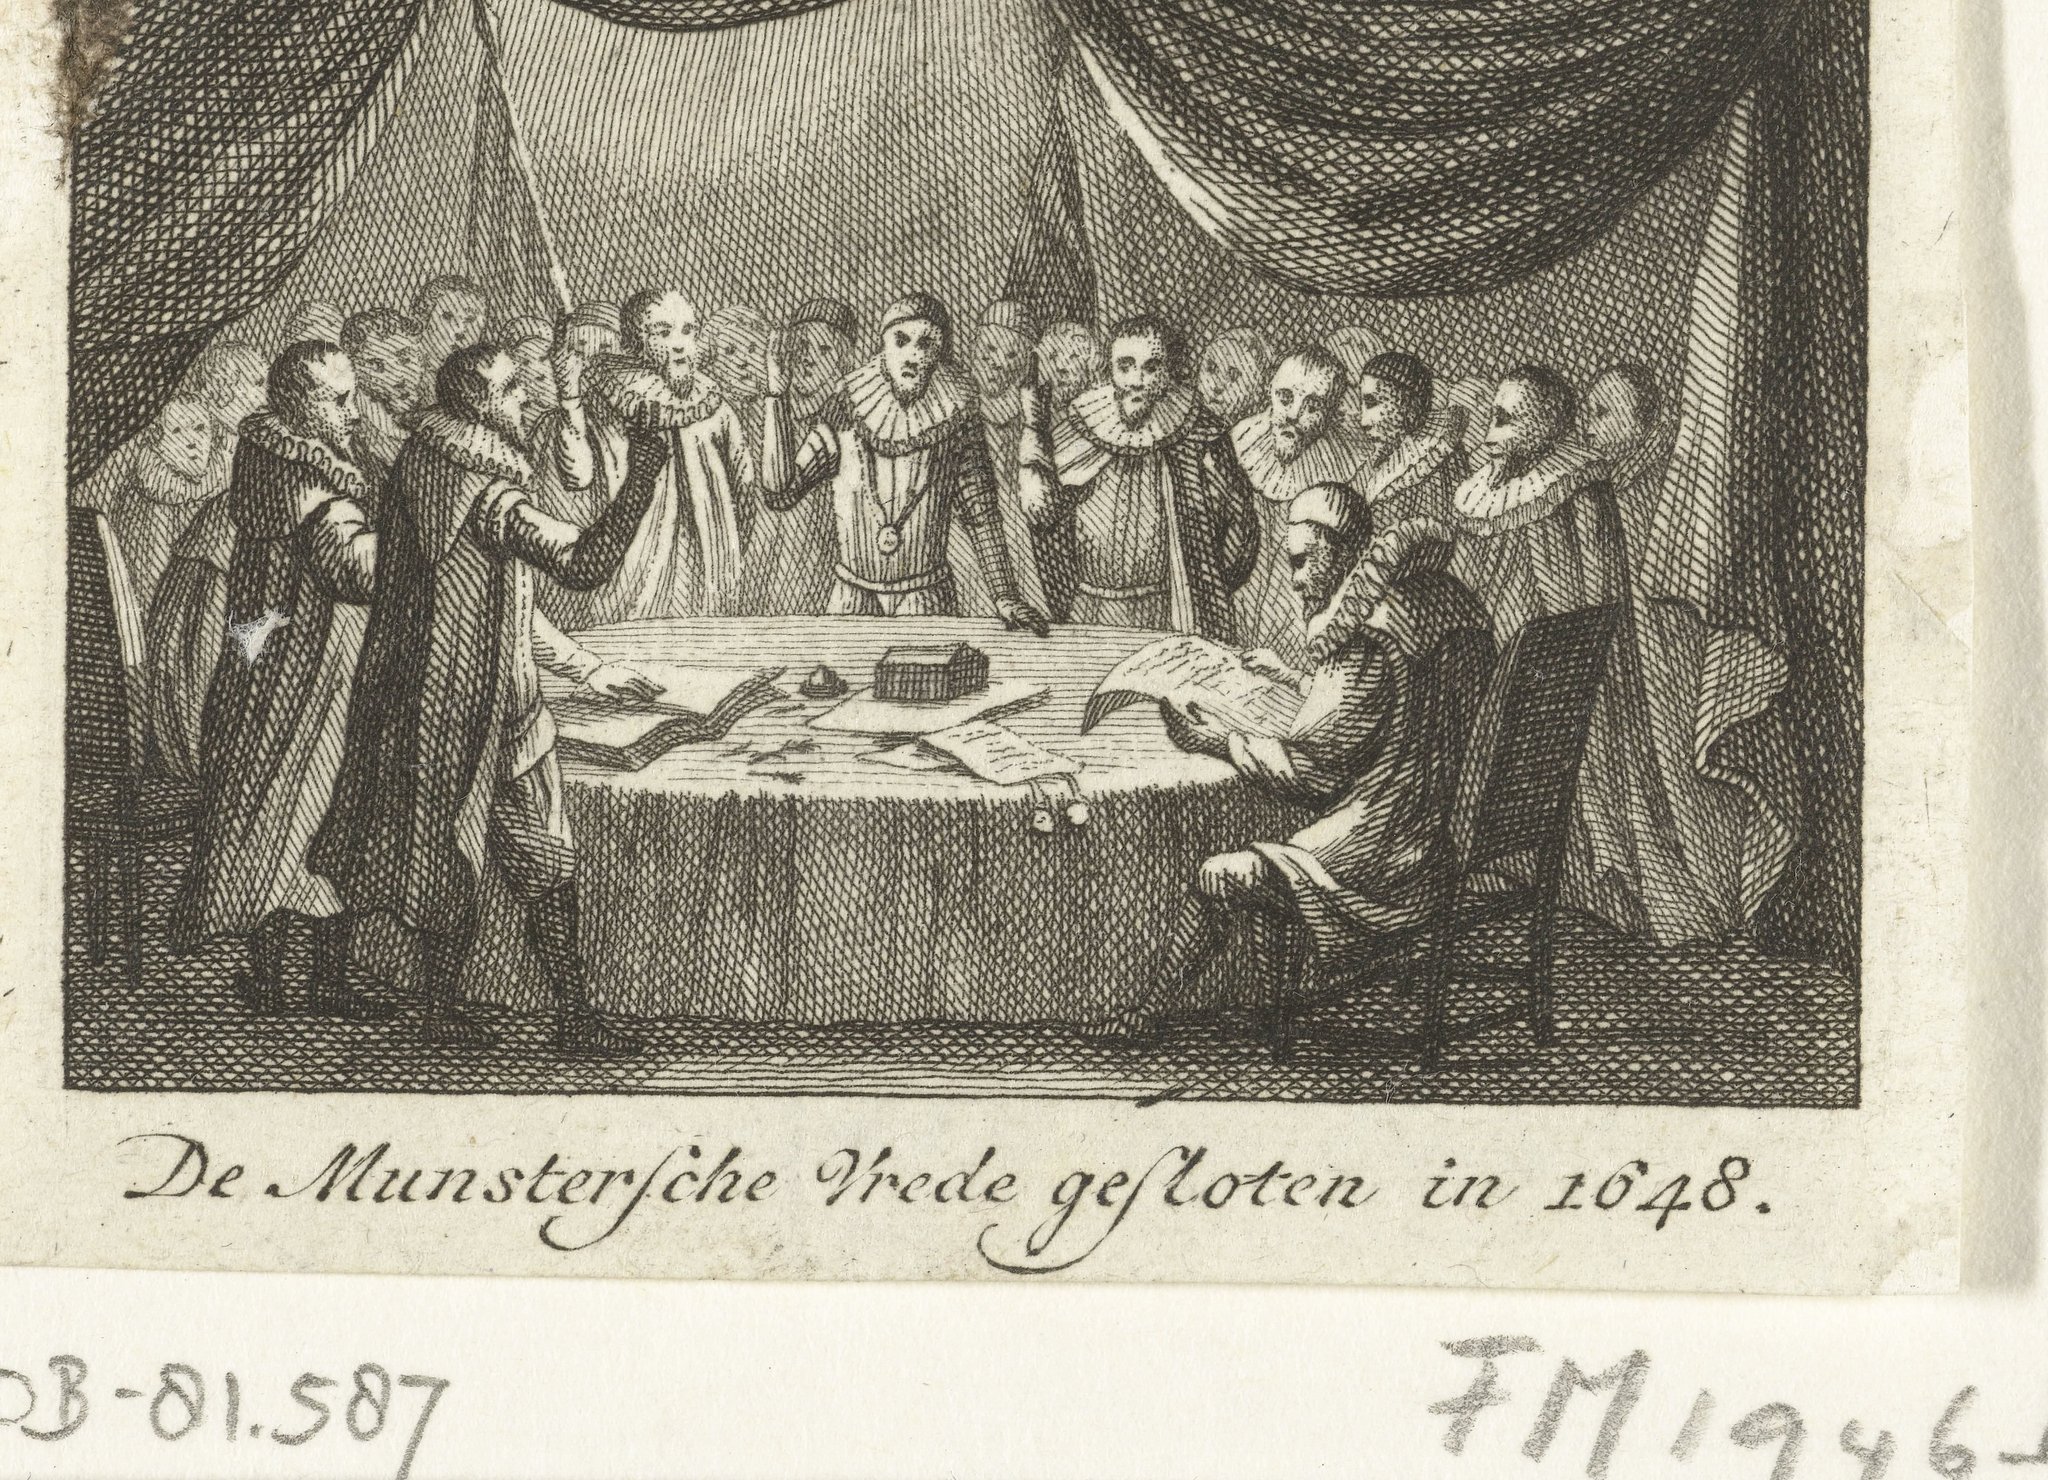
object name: print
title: Ondertekening van de Vrede van Munster, 1648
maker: carel jacob de huyser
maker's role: print maker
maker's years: 1743-1804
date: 1800-1802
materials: paper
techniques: etching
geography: netherlands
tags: signing of peace treaty, concluding the peace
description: Gebruikt als illustratie in: Vaderlands zakboekje ter bevordering van wetenschappen en fraaije letteren, of Almanak voor het jaar 1802, wed. Jan Doll, Amsterdam 1802. Dit nummer is een door het RPK toegevoegd nummer en staat niet in Frederik Muller, het werk waar de prent voor is gemaakt of uit afkomstig is, staat wel vermeld in Frederik Muller.